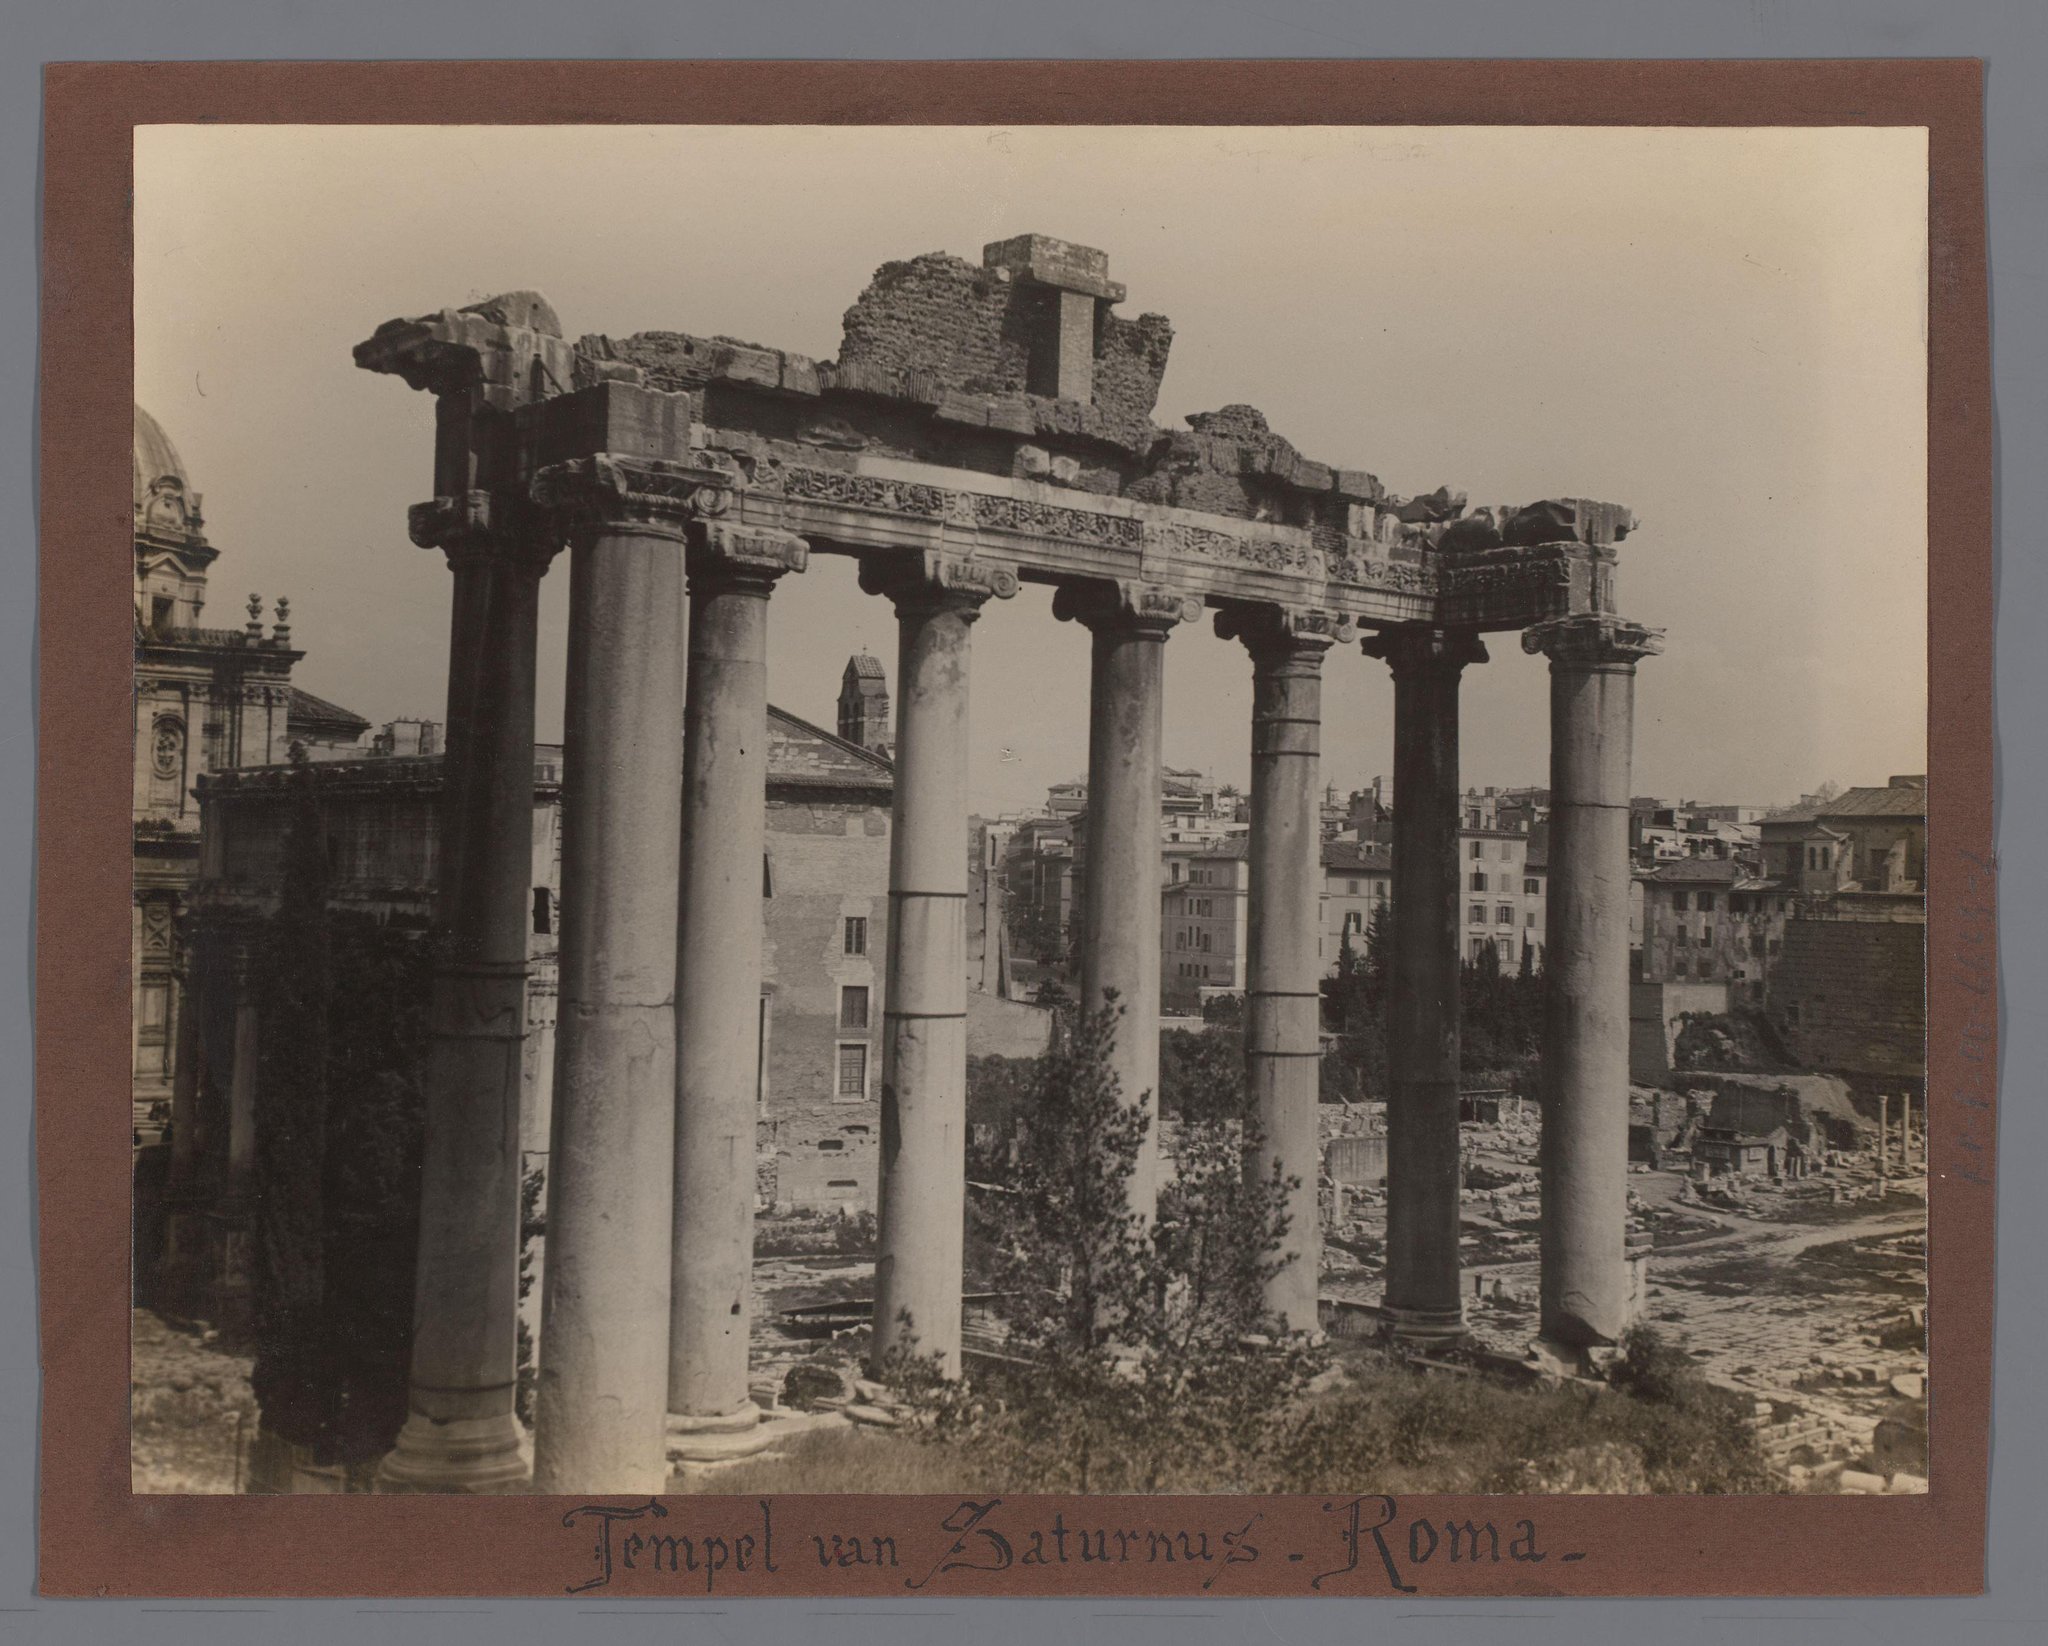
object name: photograph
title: Tempel van Saturnus, Rome, Forum Romanum, Italië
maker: Anonymous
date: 1900-1940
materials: cardboard, paper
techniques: albumen print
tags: forum romanum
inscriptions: inscription: ‘Tempel van Saturnus - Roma’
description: Tempel van Saturnus, Rome, Forum Romanum, Italië.